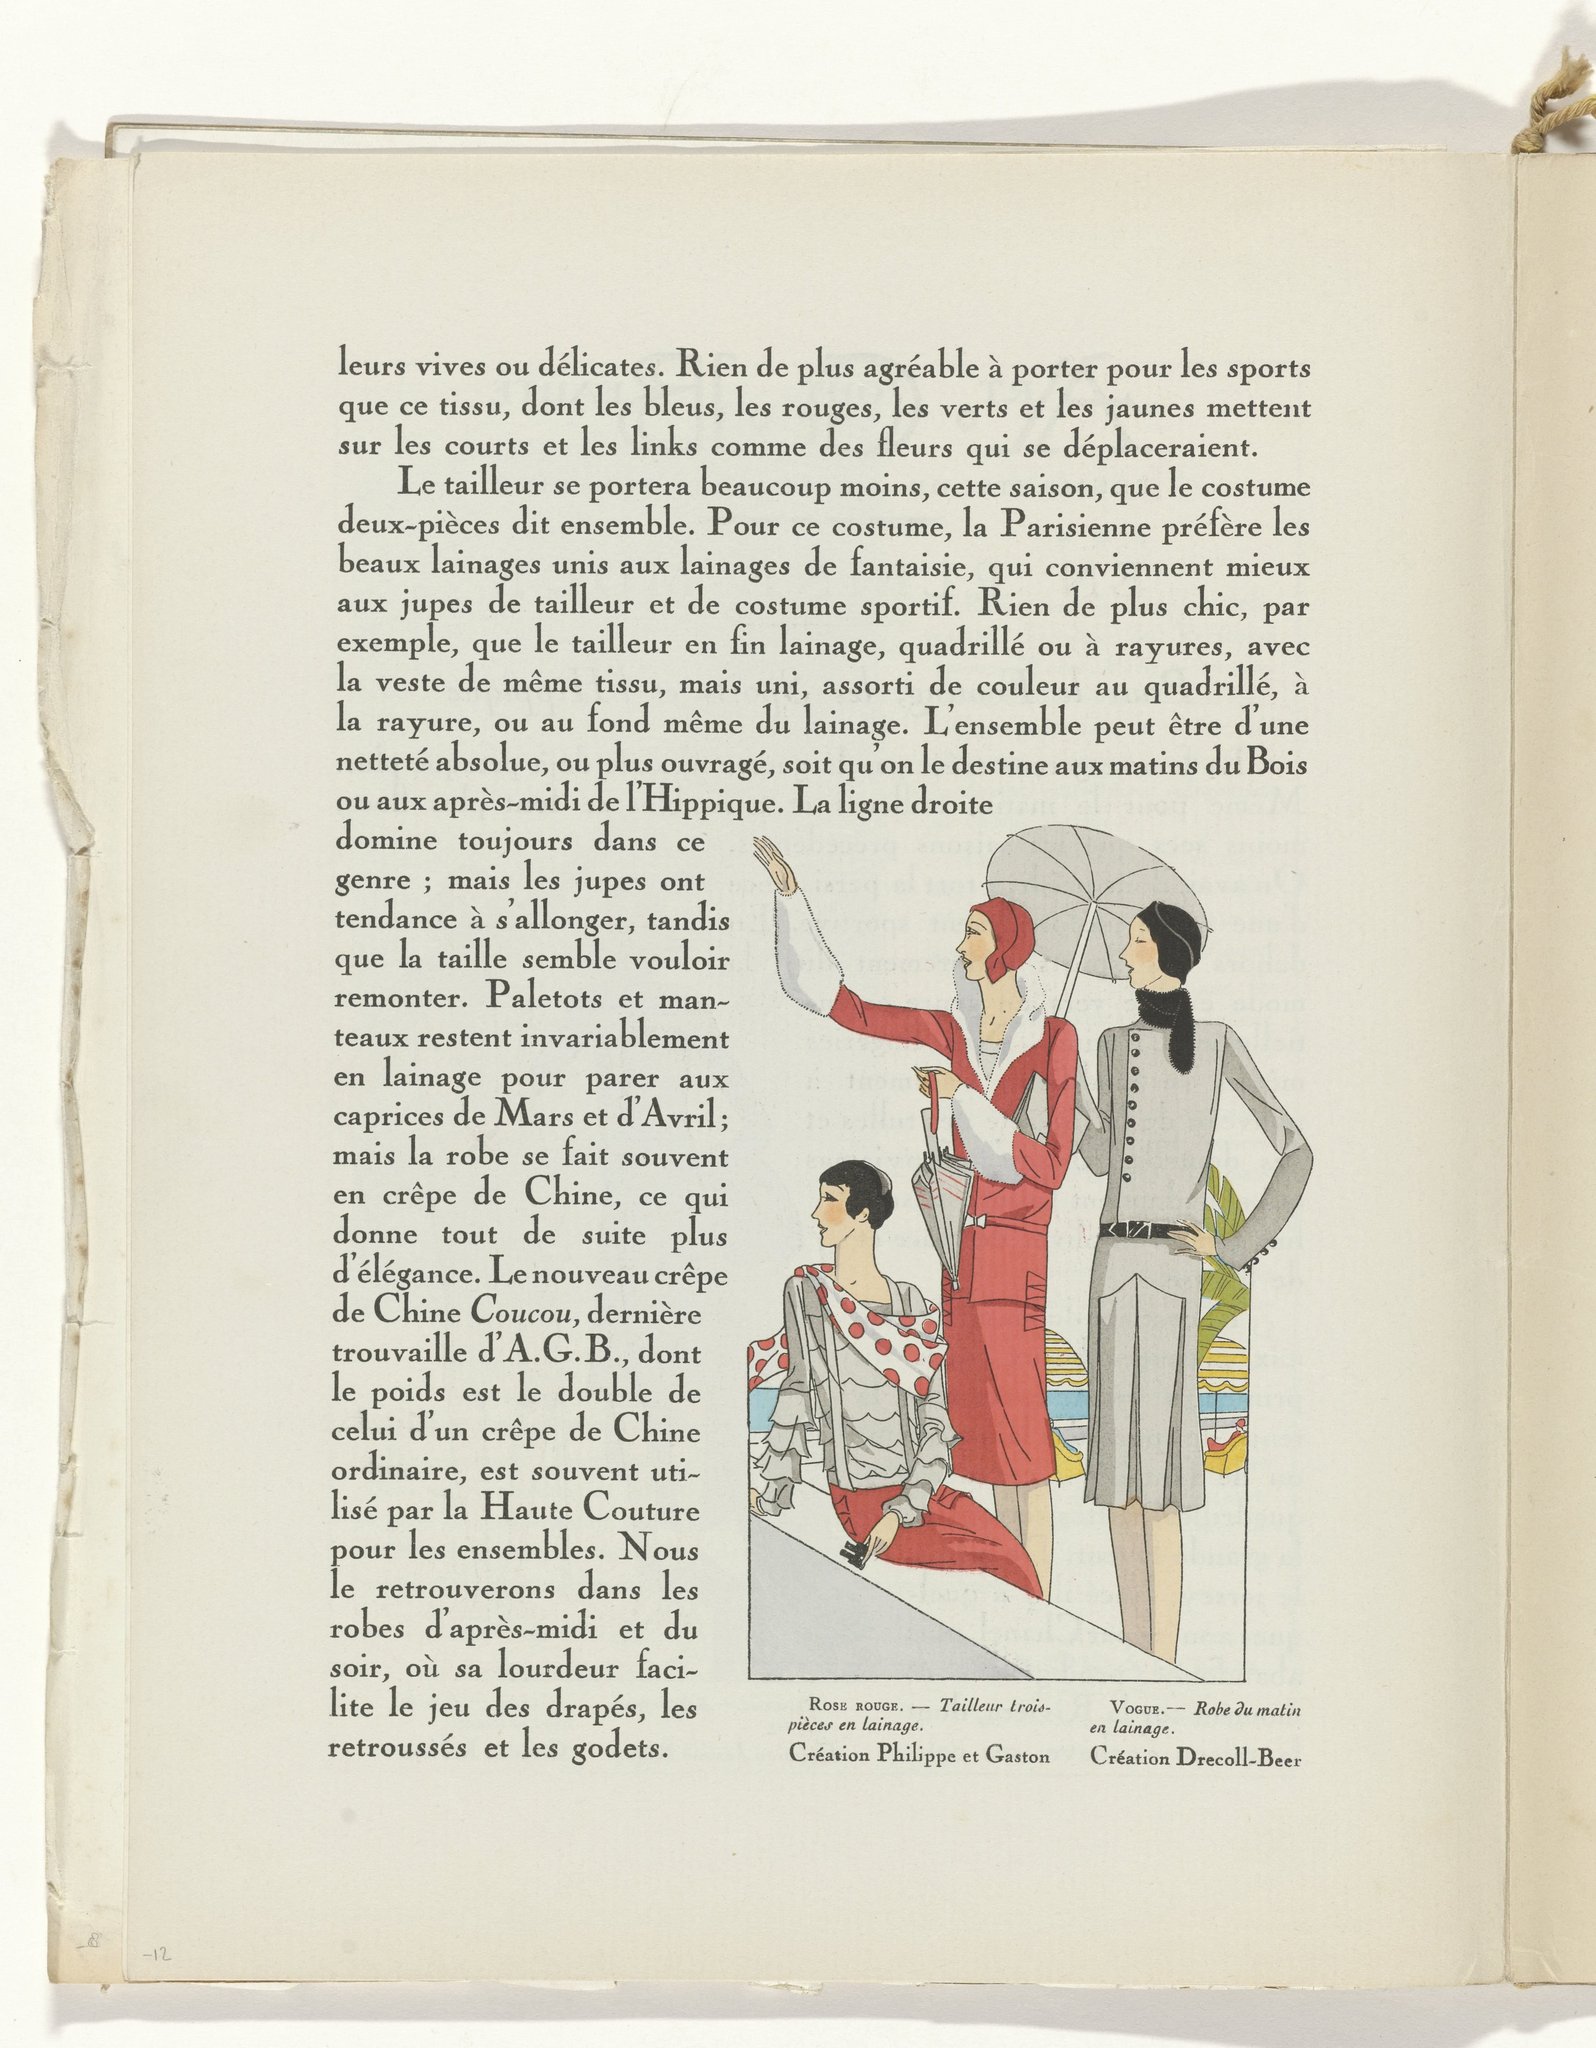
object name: magazine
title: Art - Goût - Beauté, Feuillets de l' élégance féminine, Mars 1929, No. 103, 9e Année, p. 12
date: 1929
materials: paper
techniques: hand coloring, lithograph, pochoir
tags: dress, gown: morning dress (+ women's clothes), ensembles of pieces of clothing (three piece suit) (+ women's clothes), fashion plates, head-gear: hat (+ women's clothes), neck-gear: collar (+ fur used for clothes), parasol, sunshade (+ women's clothes), belt, girdle, waistband (+ women's clothes)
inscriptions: caption: ‘ROSE ROUGE. - Tailleur trois-pièces en lainage. Création Philippe et gaston / VOGUE. - Robe du matin en lainage. Création Drecoll-Beer’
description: Tekst met een illustratie van drie vrouwen op een terras. Links: tailleur trois-pièces (mantelpak) van rode wol, van Philippe et Gaston. Rechts: ochtendjapon van grijze wol, van Drecoll-Beer. Pagina uit het modetijdschrift Art-Goût-Beauté (1920-1933).